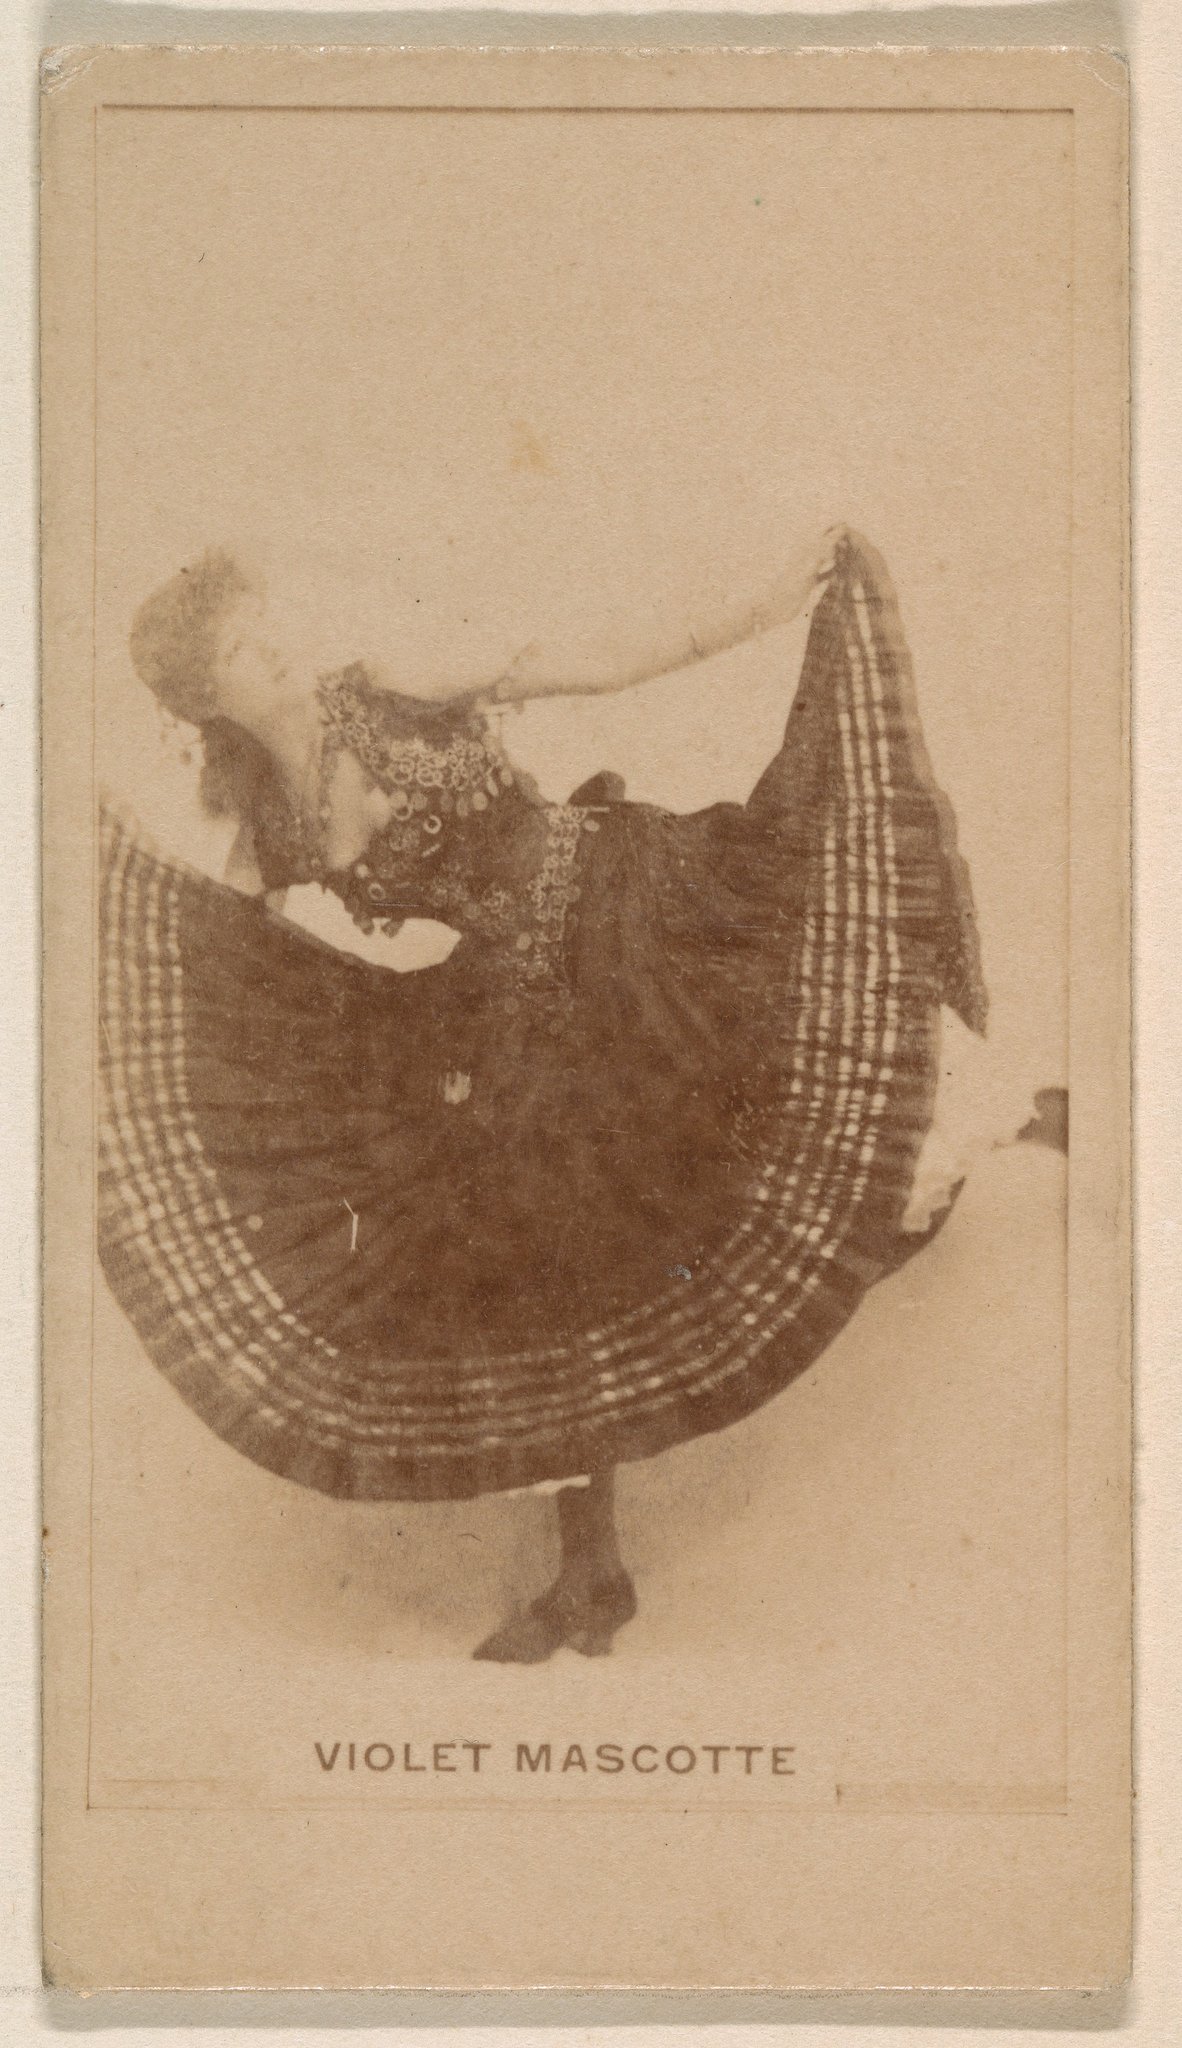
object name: photograph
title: Violet Mascotte, from the Actresses series (N245) issued by Kinney Brothers to promote Sweet Caporal Cigarettes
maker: kinney brothers tobacco company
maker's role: publisher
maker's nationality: american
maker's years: 1869-2011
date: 1890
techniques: albumen silver print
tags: portraits,women,actresses